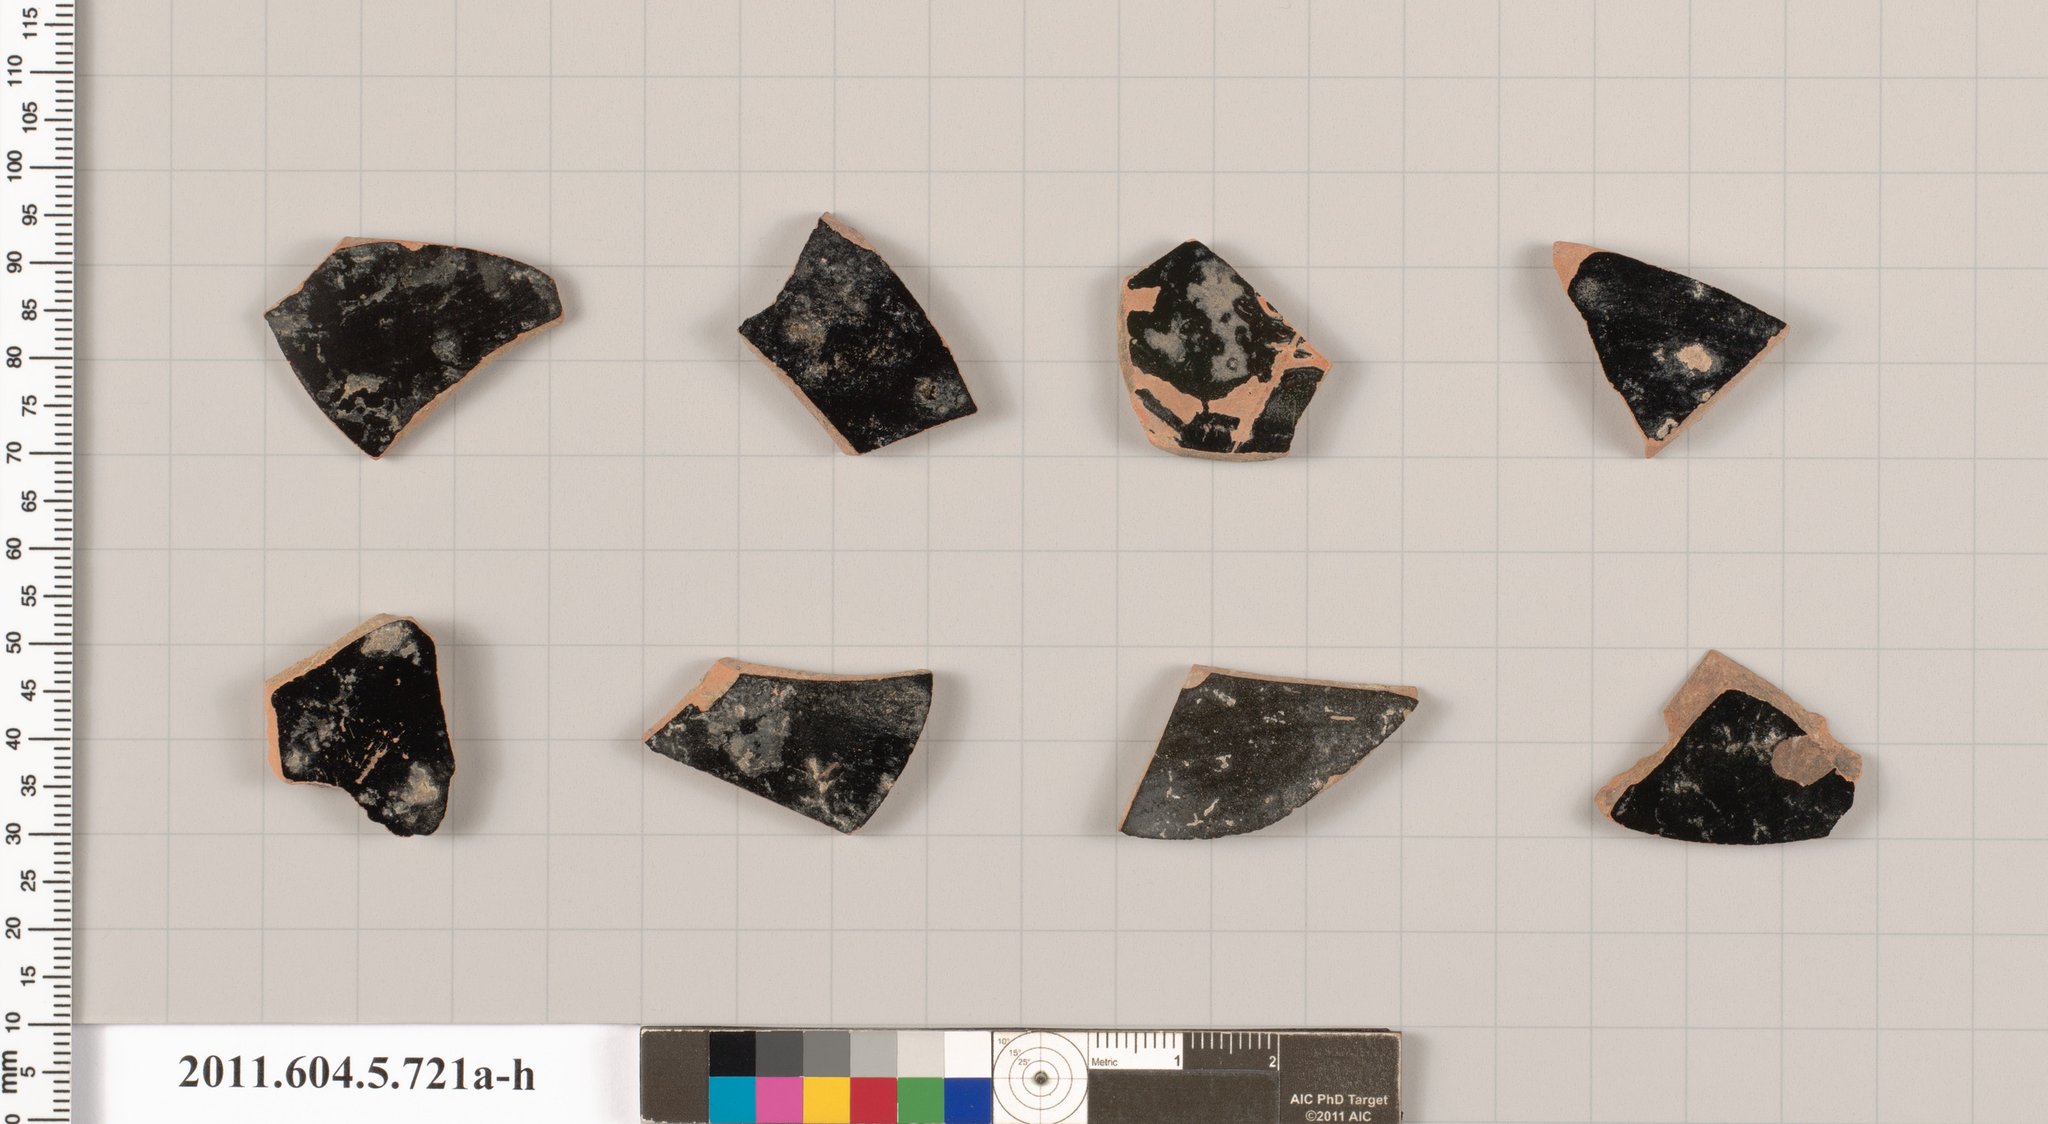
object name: kylix fragment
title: Terracotta fragments of kylikes (drinking cups)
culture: greek, attic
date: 600-401 BCE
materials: terracotta